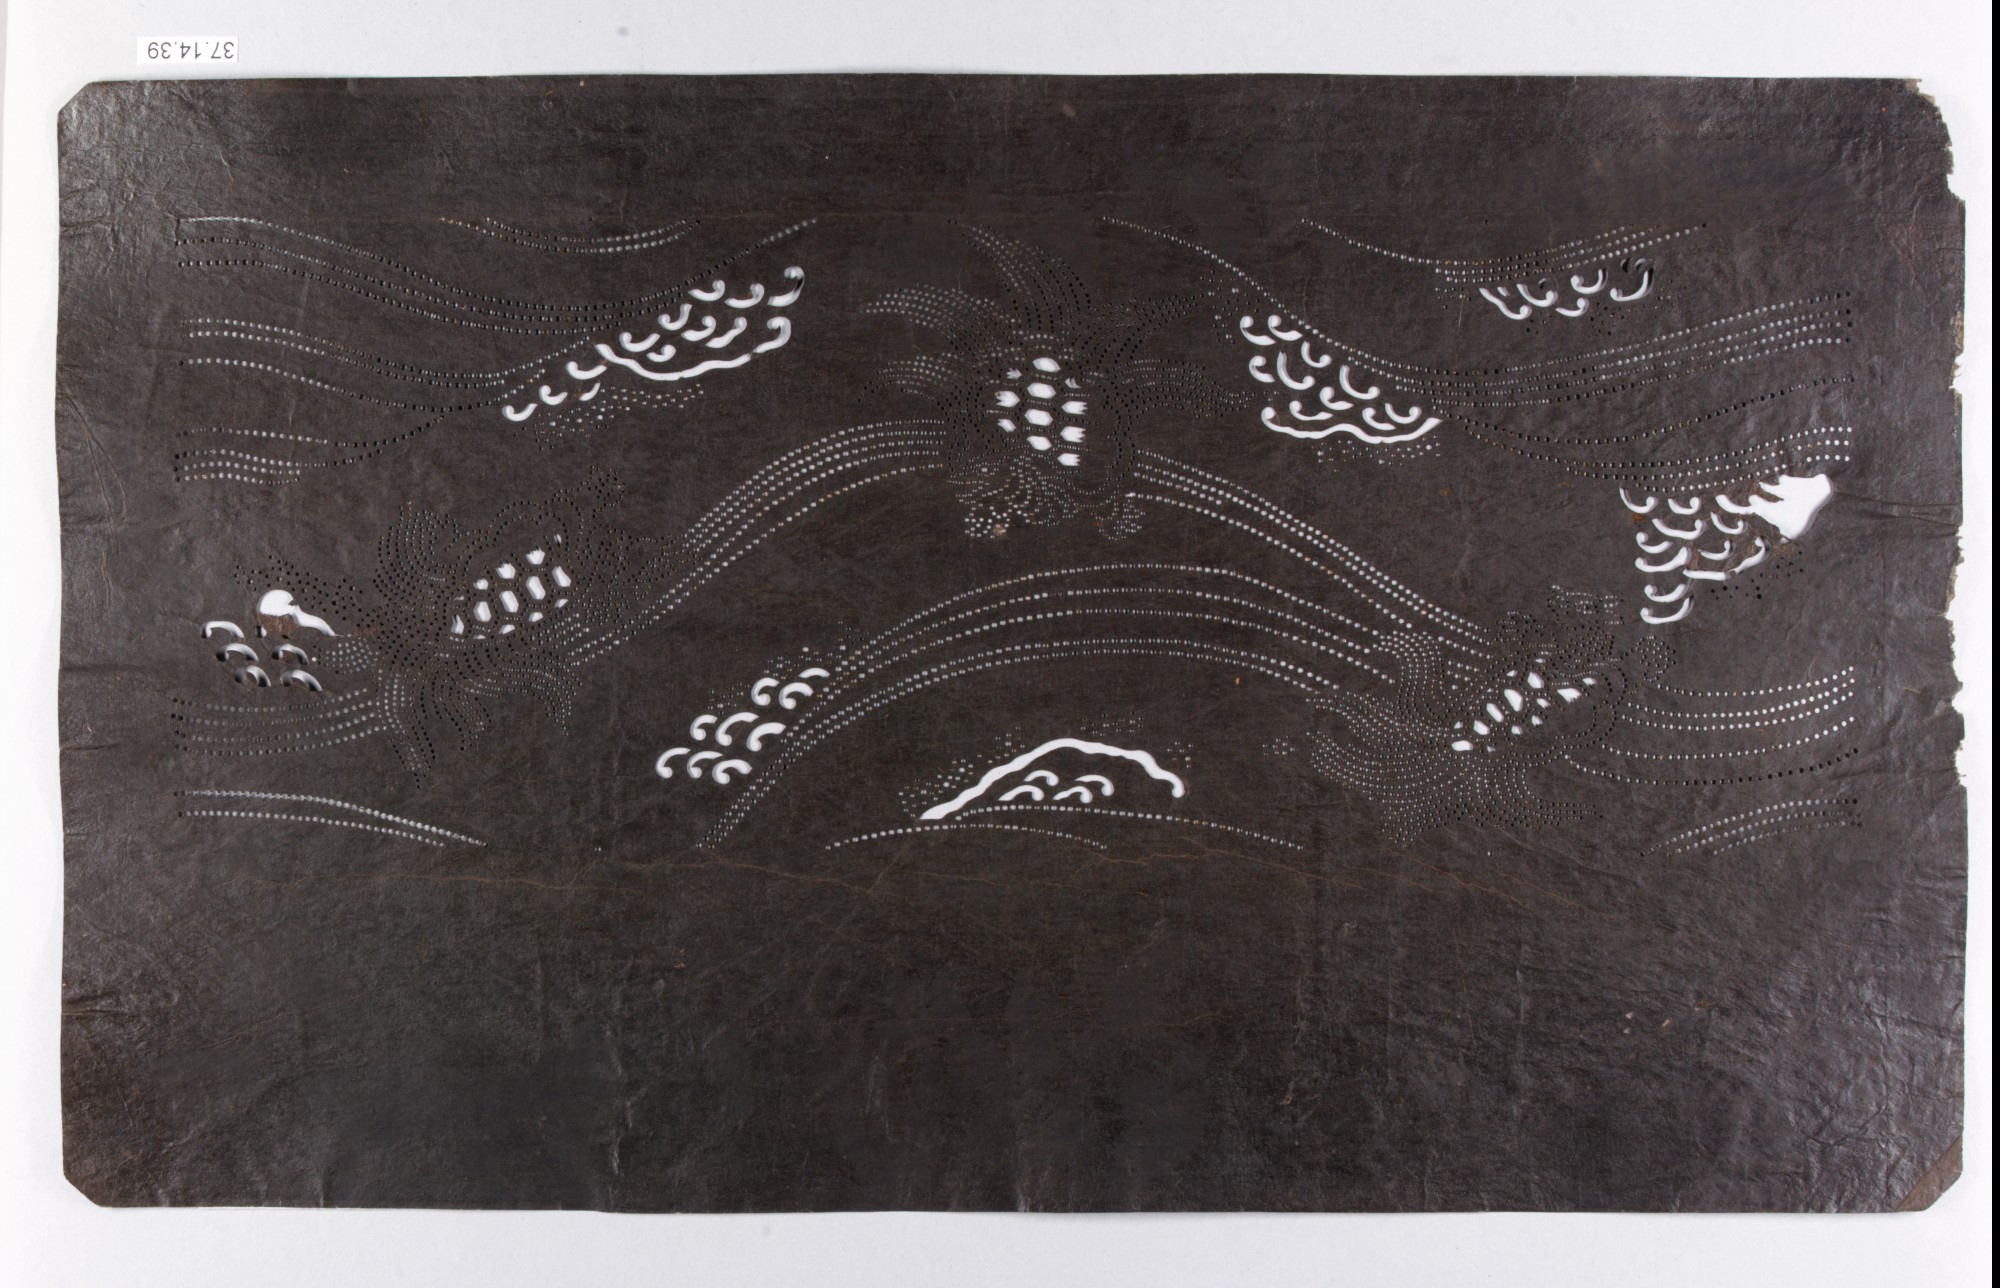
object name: stencil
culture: japanese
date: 1801-1833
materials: paper